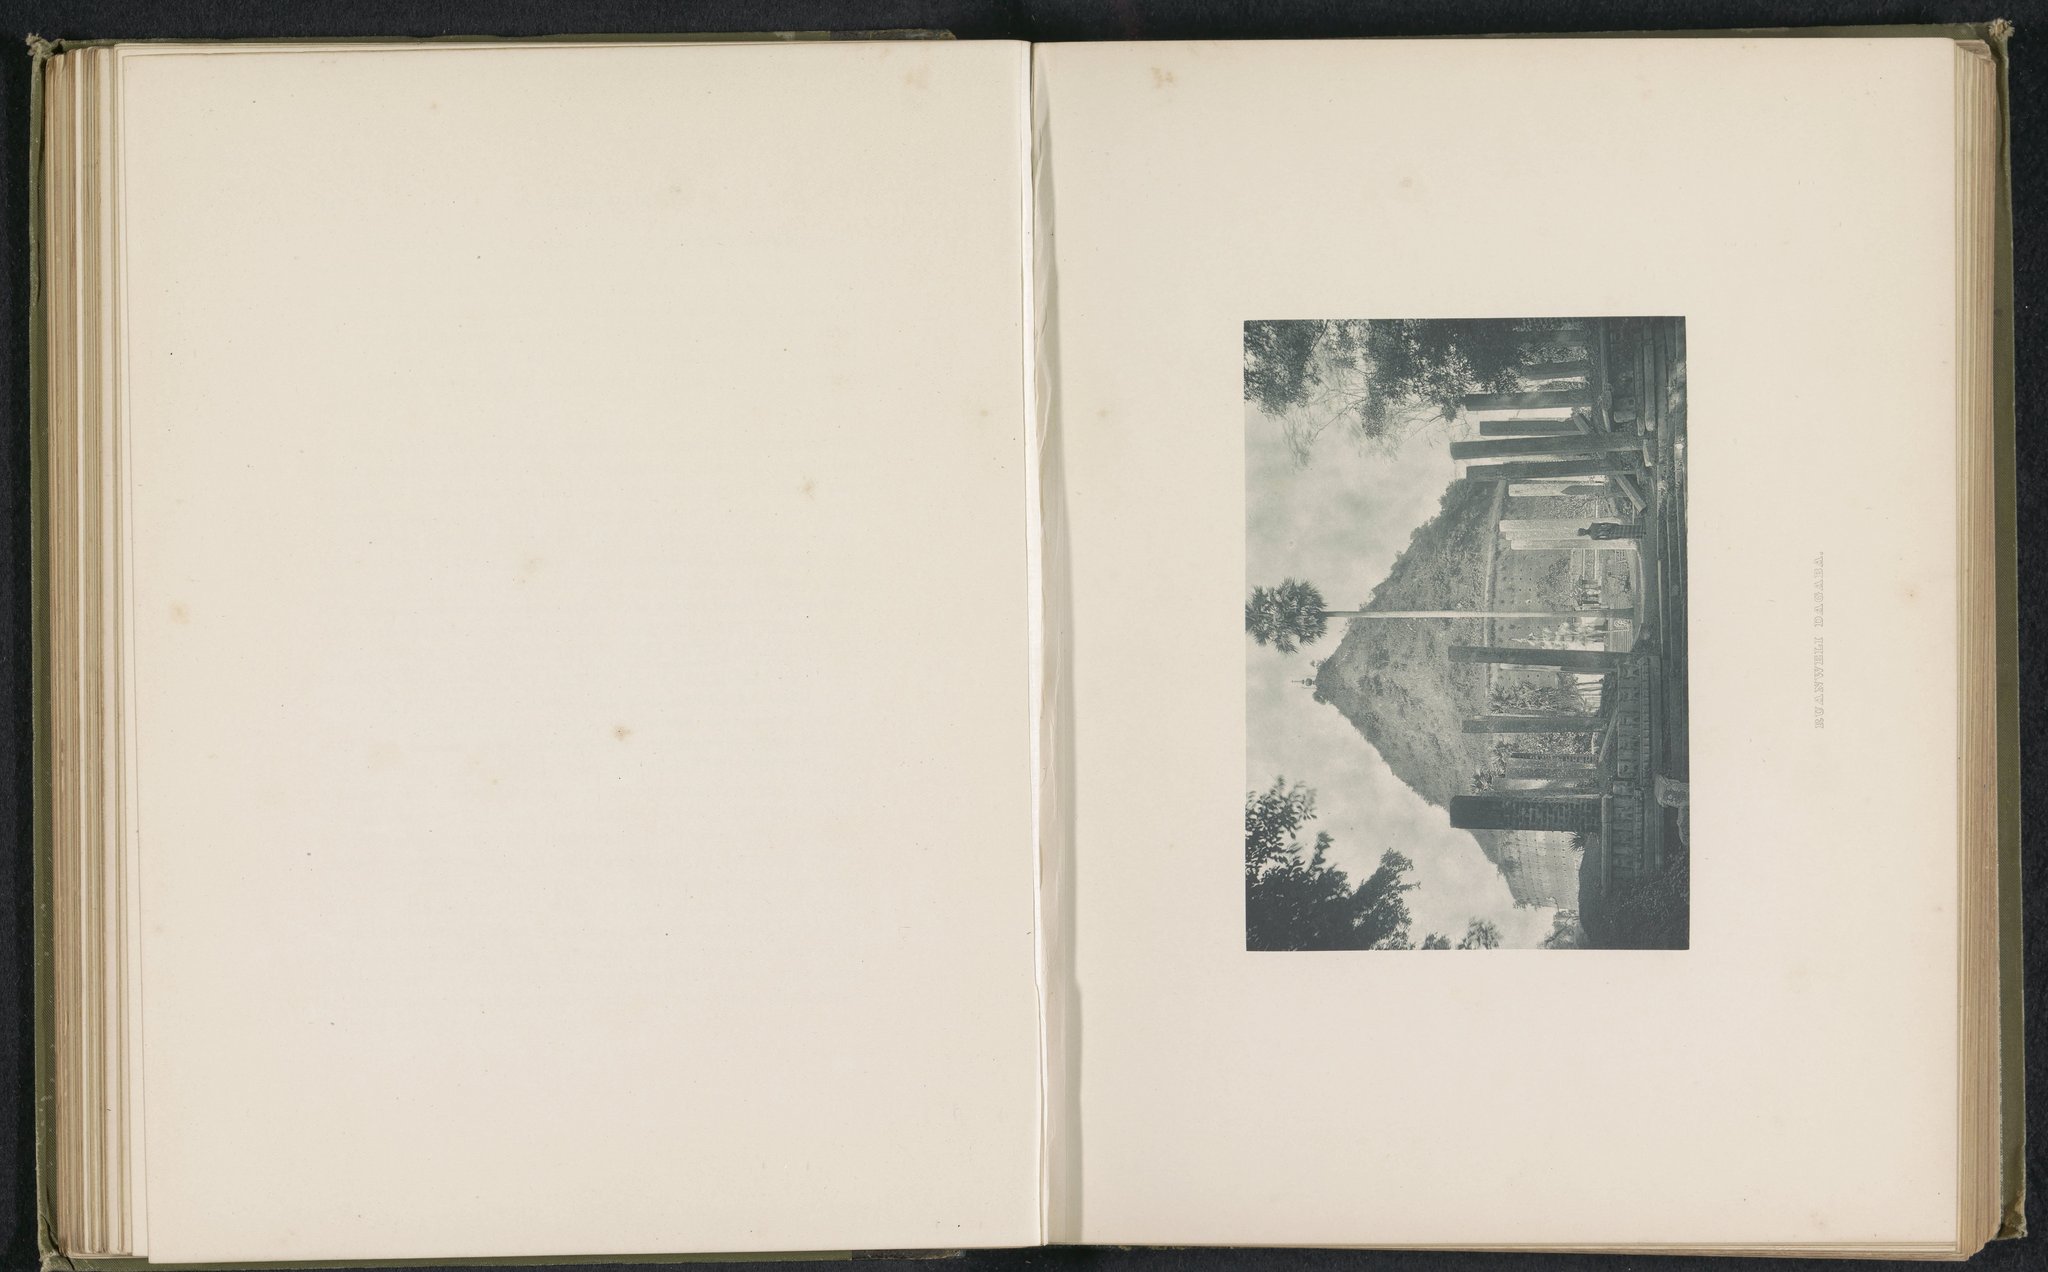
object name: photomechanical print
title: Ruins of the Ruwanwelisaya stupa at Anuradhapura, Sri Lanka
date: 1896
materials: paper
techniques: woodburygravure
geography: anuradhapura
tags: temple, shrine ~ hinduism, buddhism, jainism, ruin of a building ~ architecture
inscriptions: title: ‘RUANWELI DAGABA.’